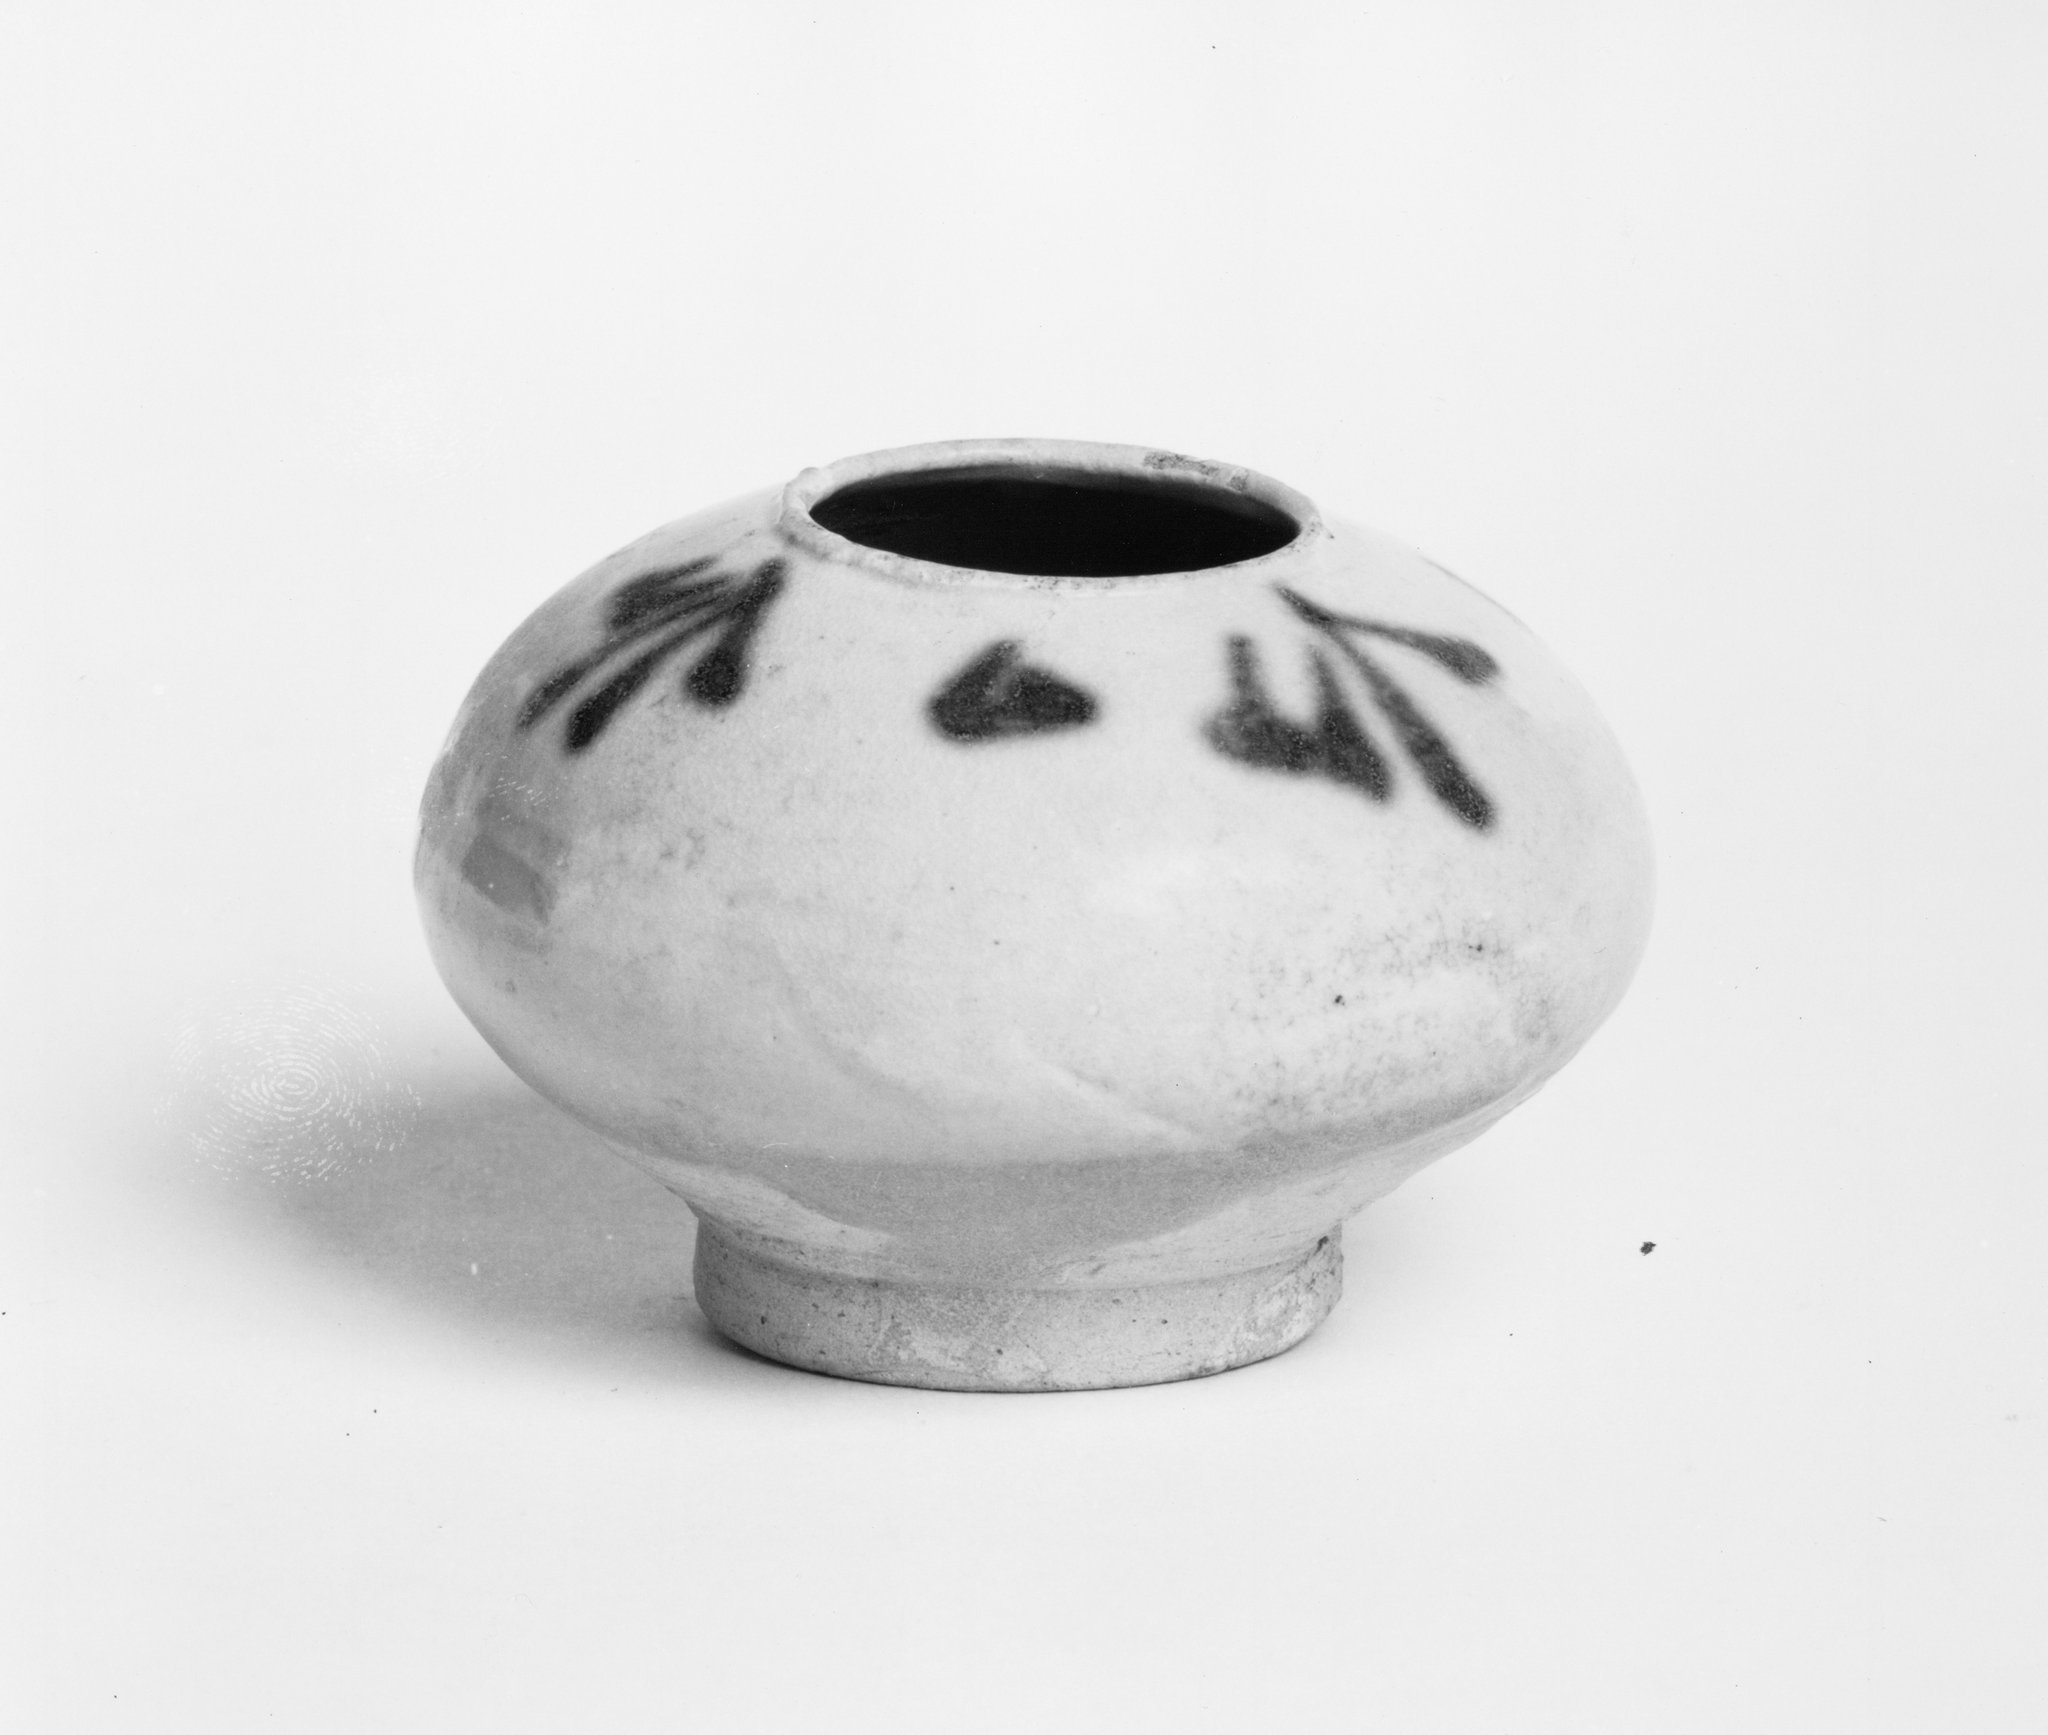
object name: water pot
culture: chinese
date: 801-900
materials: glaze, stoneware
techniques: painting